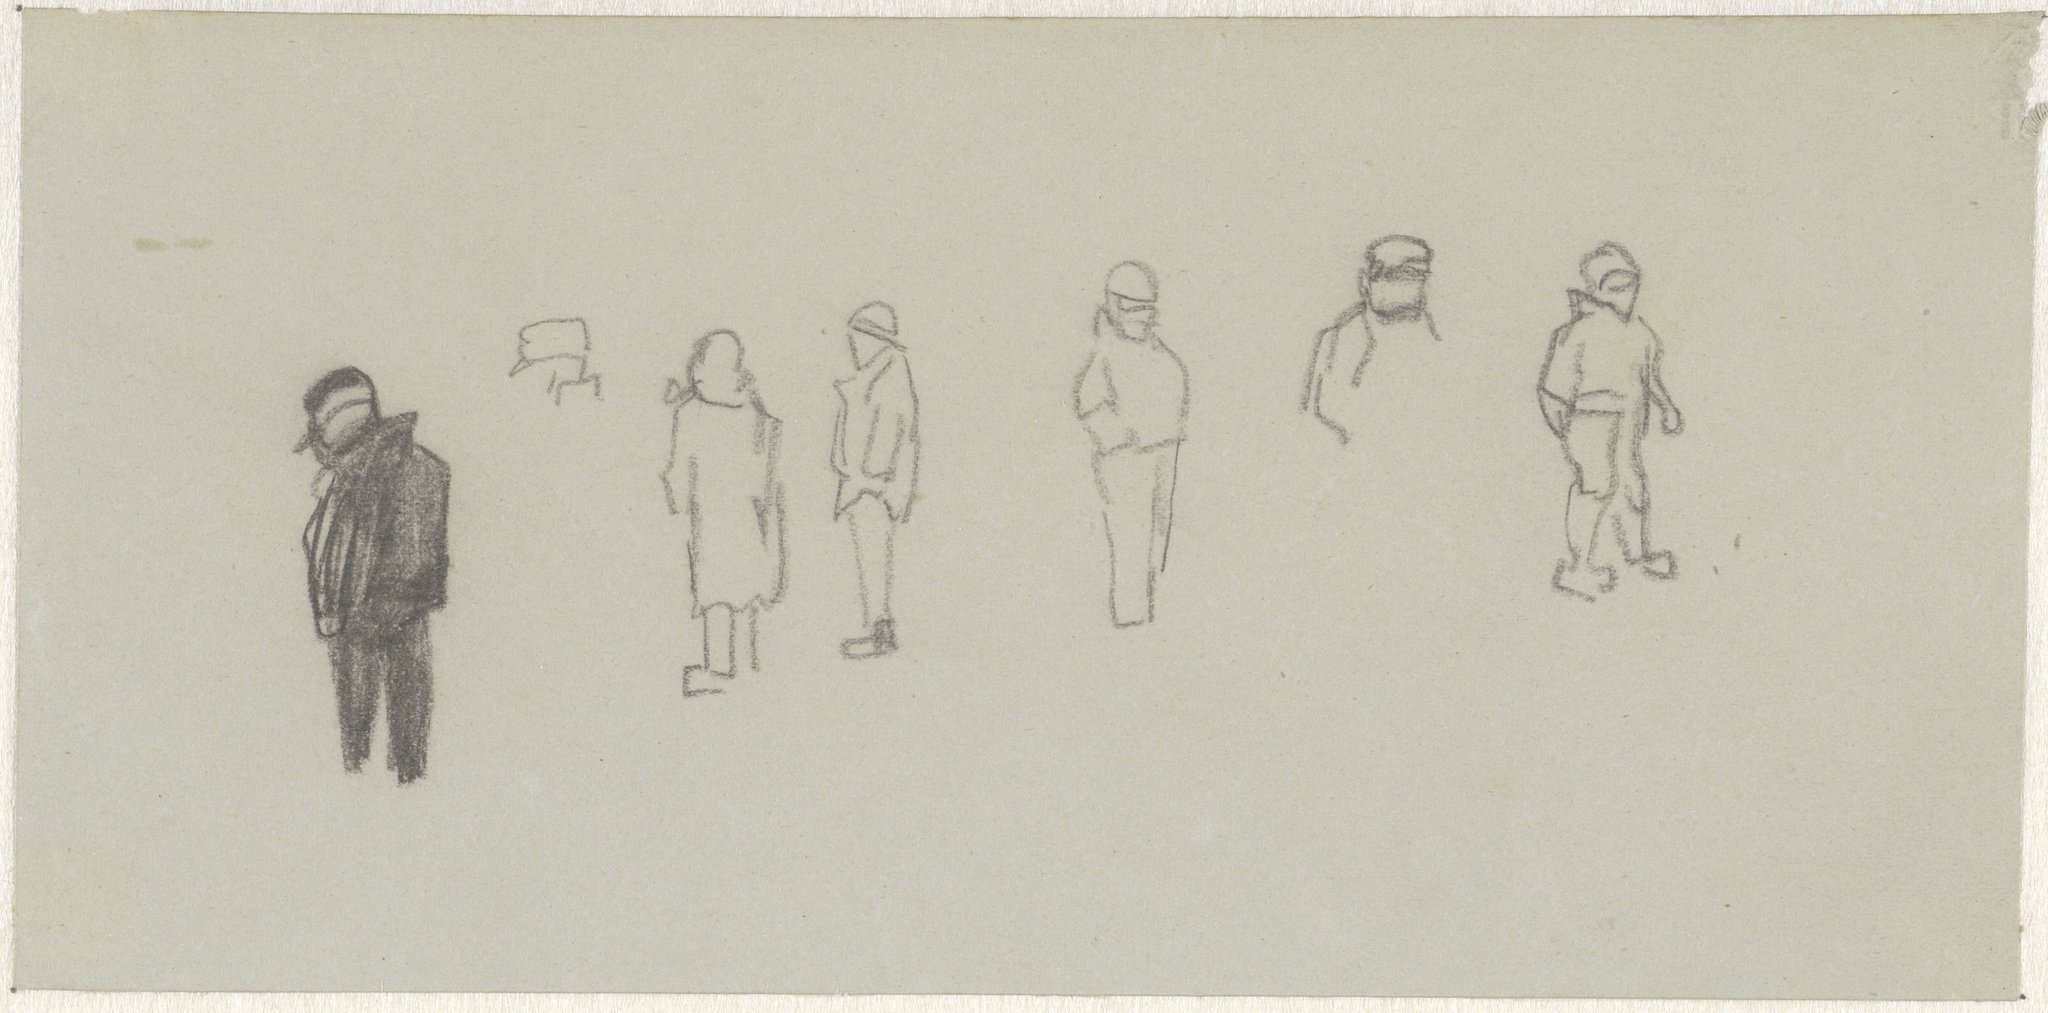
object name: drawing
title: Schetsen van kinderen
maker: anton mauve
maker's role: draughtsman, painter, print maker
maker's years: 1838-1888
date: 1848-1888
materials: chalk, paper